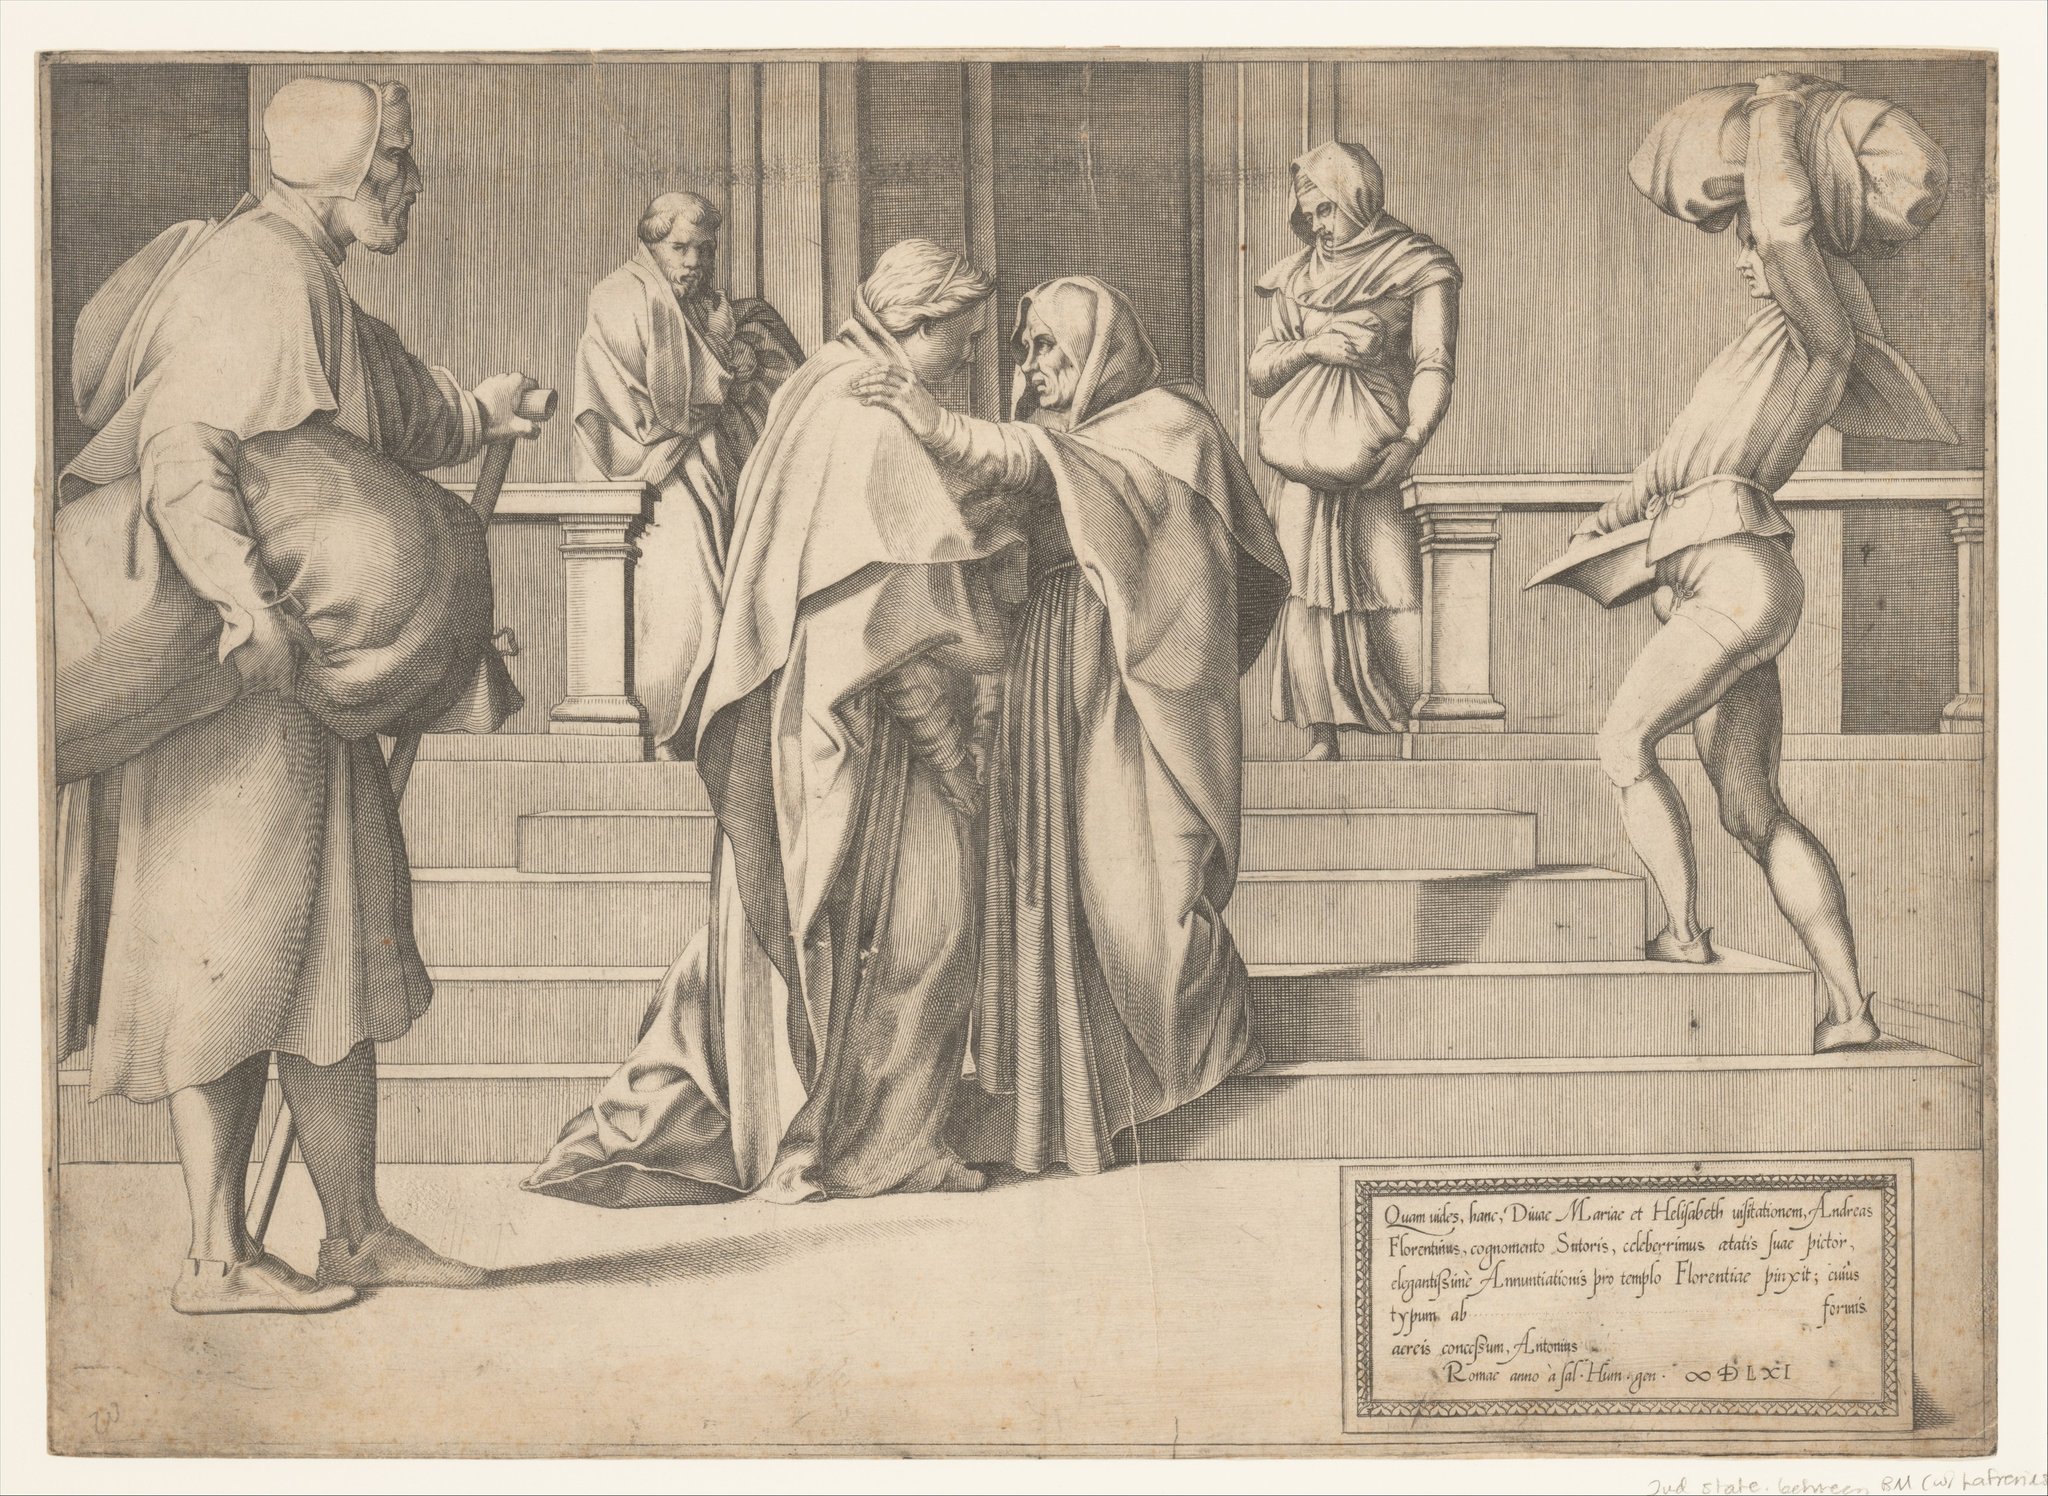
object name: print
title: The Visitation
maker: enea vico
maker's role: artist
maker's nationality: italian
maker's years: 1523-1567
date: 1561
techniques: engraving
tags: men,women